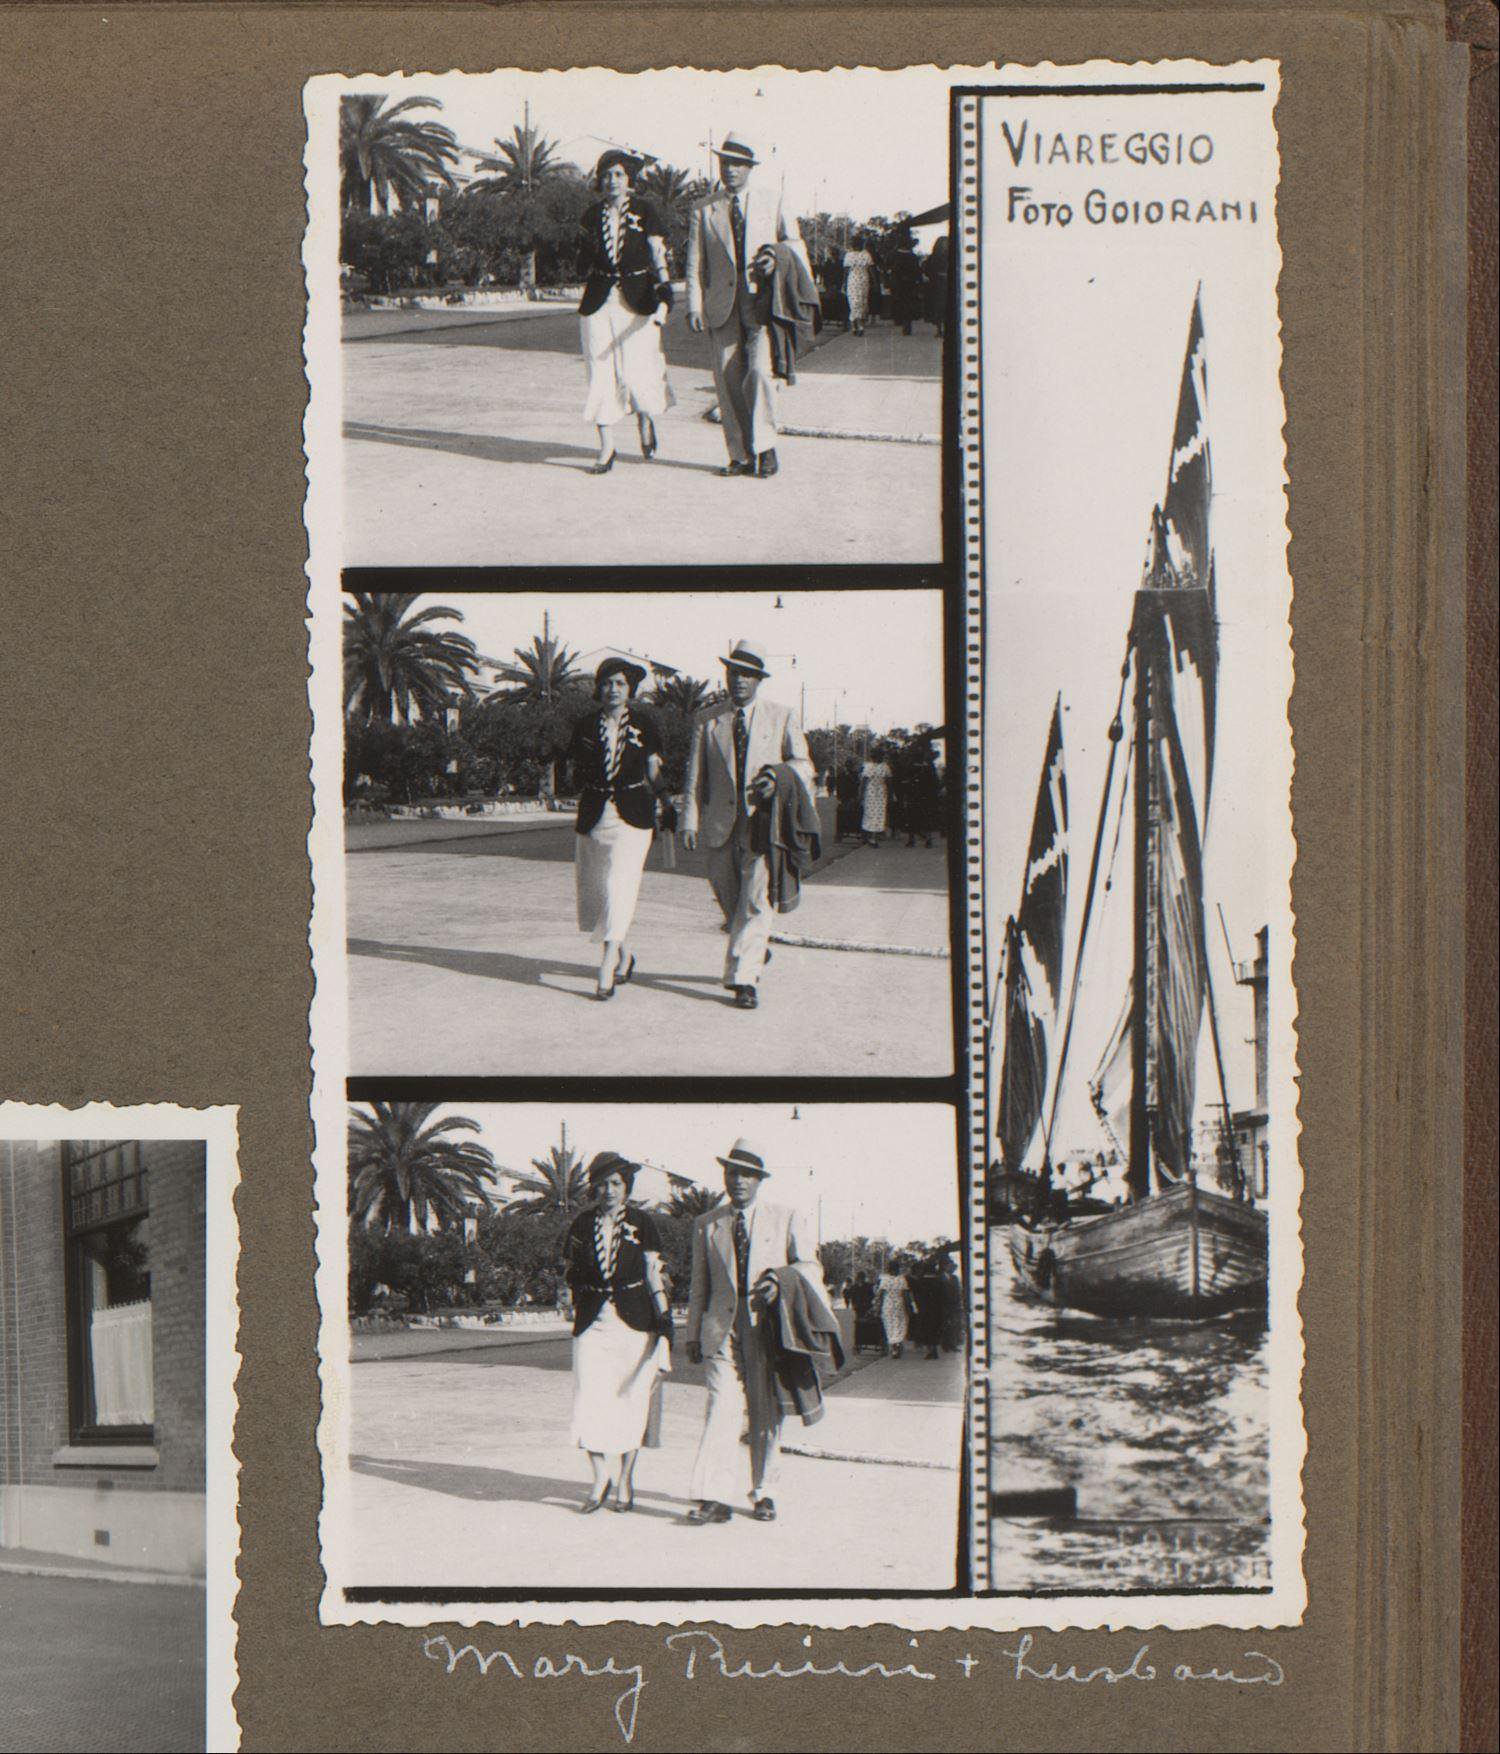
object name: photograph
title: Drie opnamen van Maria Ruini en haar man, wandelend in Viareggio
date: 1933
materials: paper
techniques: gelatin silver print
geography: viareggio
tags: strolling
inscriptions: inscription: ‘Mary Ruini + husband’